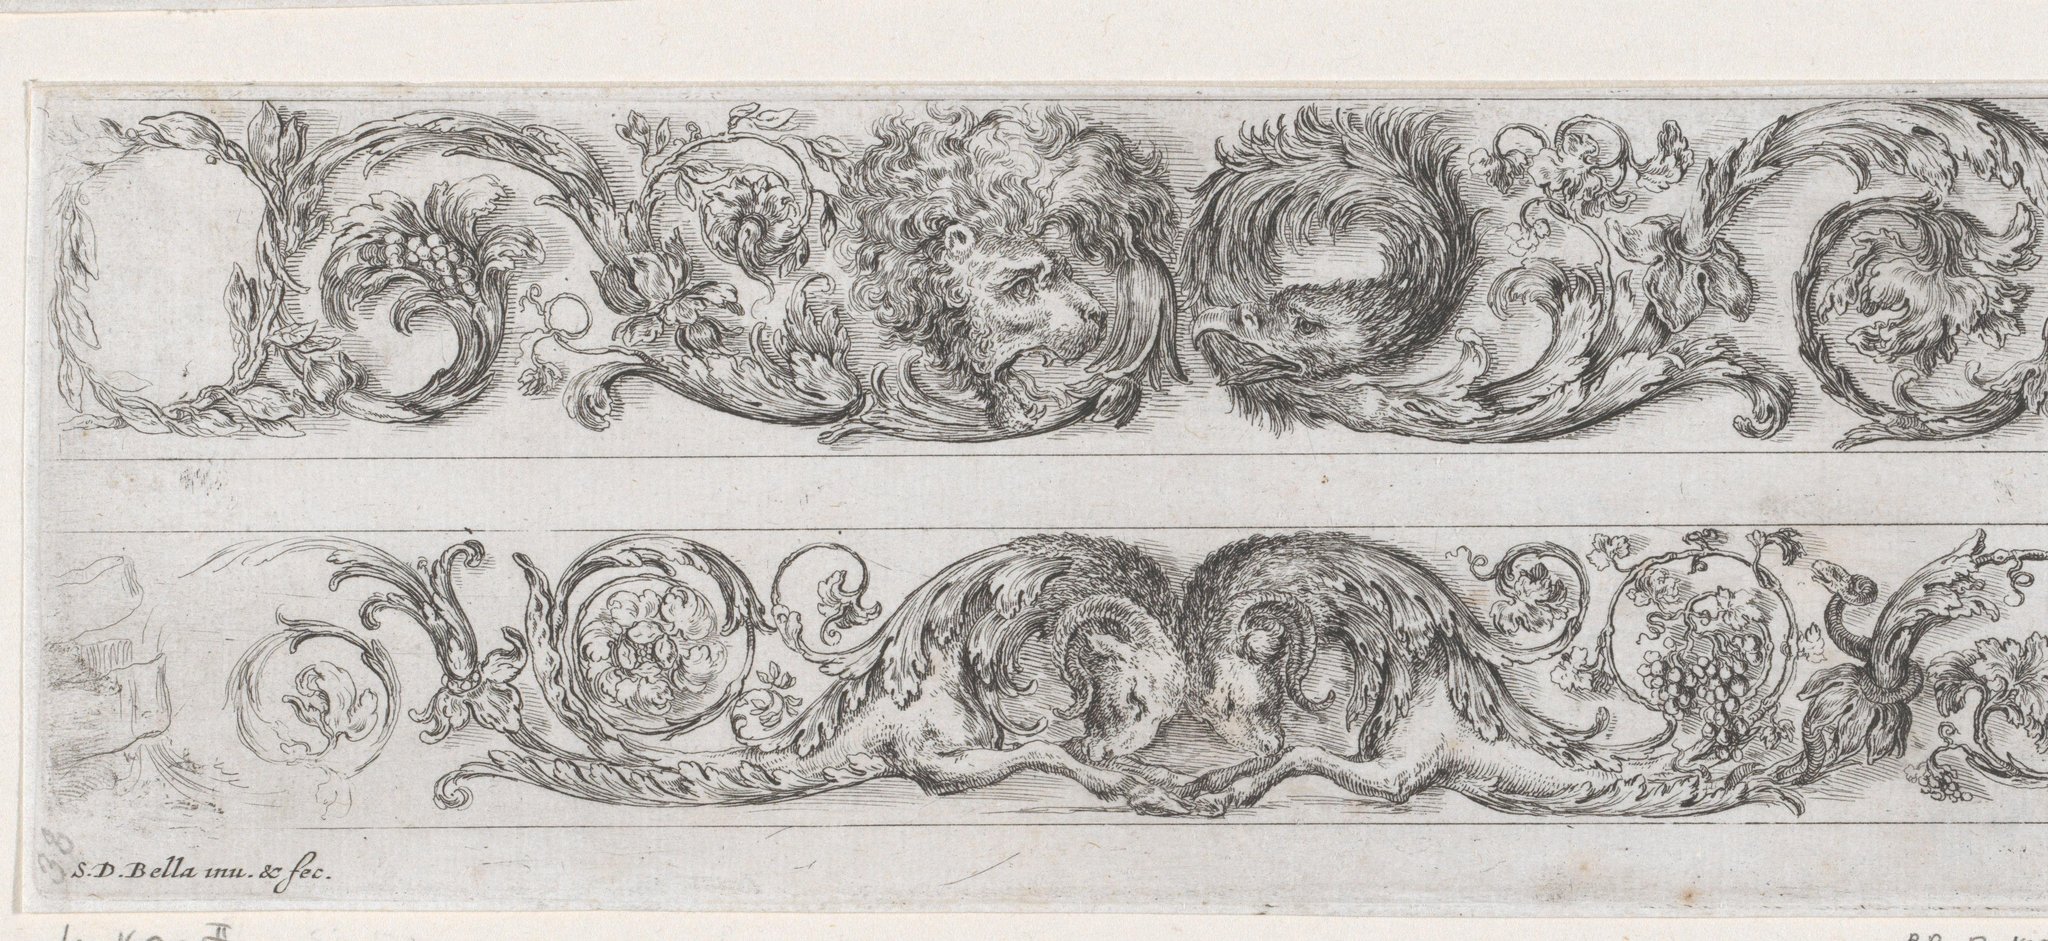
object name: print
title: Ornamenti di fregi et fogliani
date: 1620-1664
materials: paper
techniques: etching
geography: france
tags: lion's head ~ ornament, ram's head ~ ornament, foliage ~ ornament, predatory birds: eagle (+ ornamental variants of animals)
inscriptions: collector's mark: Lugt 2228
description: Twee friezen. Boven: een fries met links een leeuwenkop uitlopend in bladornament en rechts een kop van een adelaar uitlopend in bladornament. Onder: twee tegen elkaar opbotsende rammen die uitlopen in bladornament.